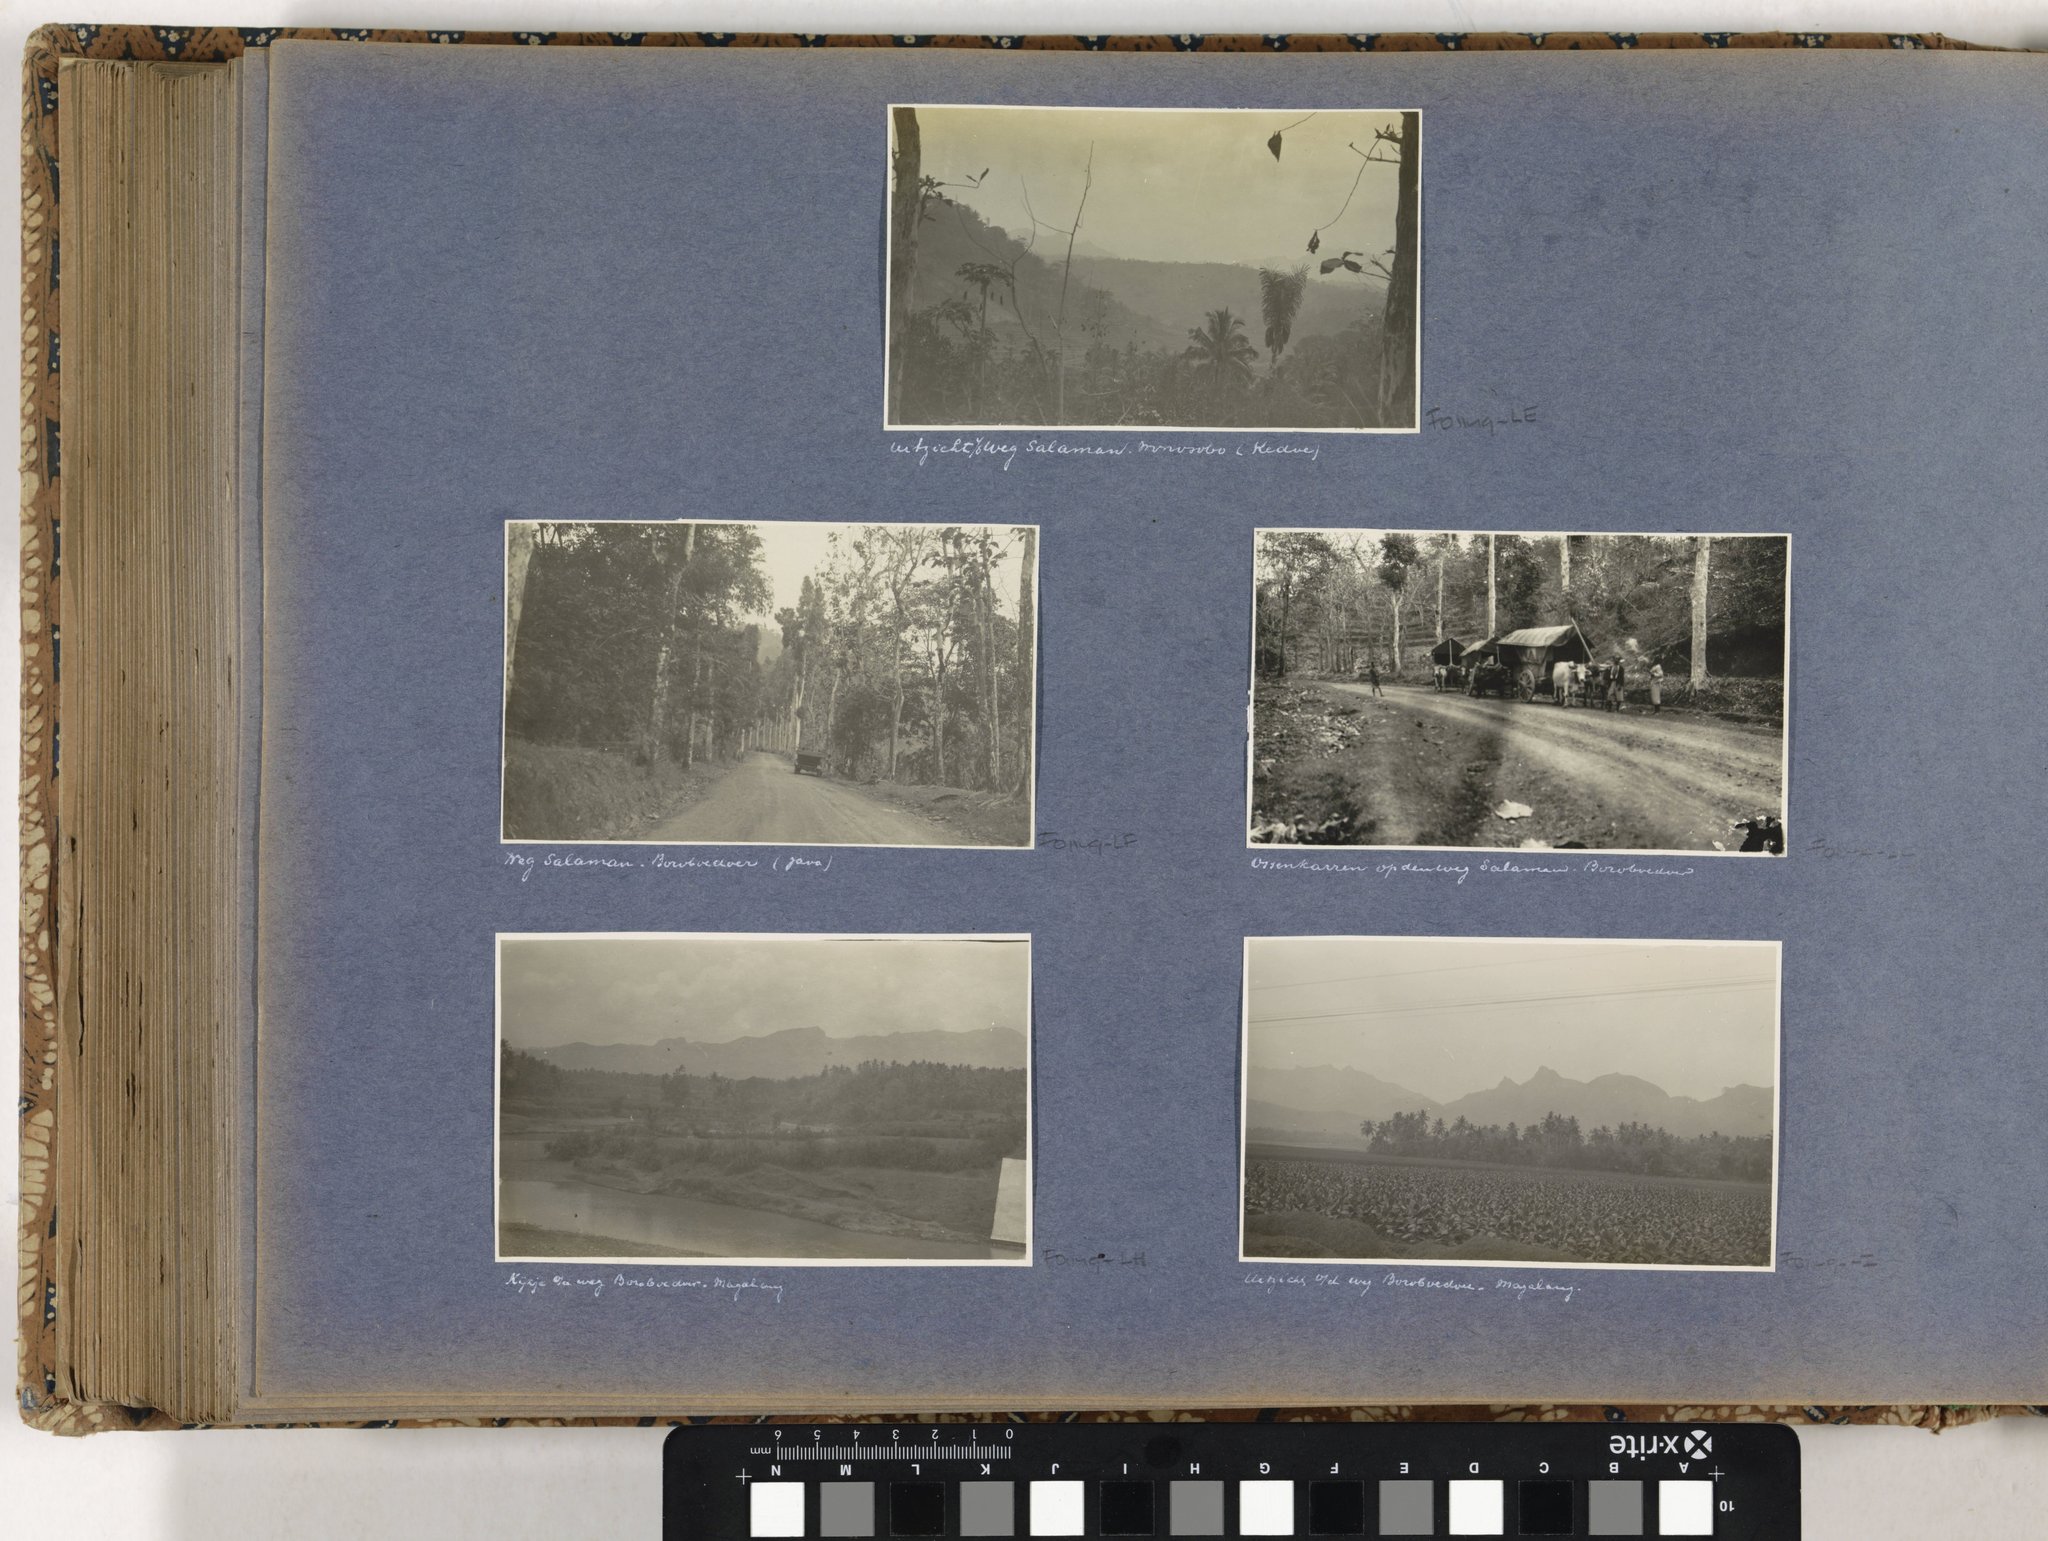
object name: photograph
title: Ossenkarren op de weg van Salaman naar Borobudur op Java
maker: Anonymous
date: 1900-1920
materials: paper, photographic support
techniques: gelatin silver print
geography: java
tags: two-wheeled, animal-drawn vehicle, road, path, java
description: Onderdeel van reisalbum met foto's van bedrijvigheid en bezienswaardigheden op Sumatra en Java en van de reis naar en van Nederlands-Indië.